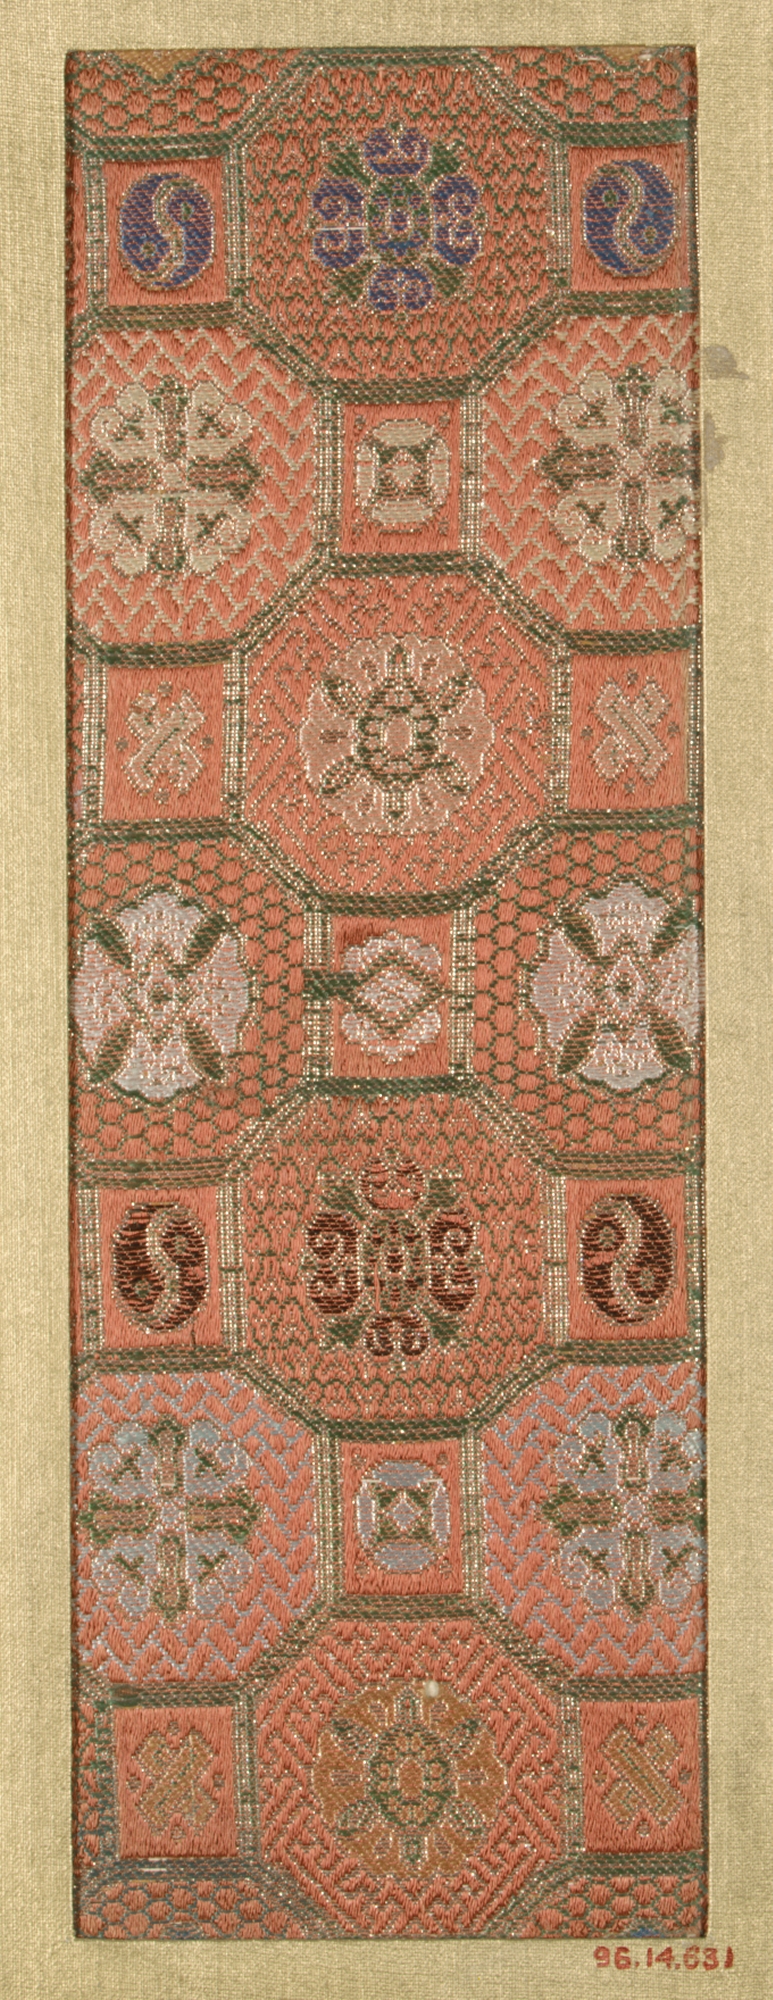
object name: piece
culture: japanese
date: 1701-1900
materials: silk